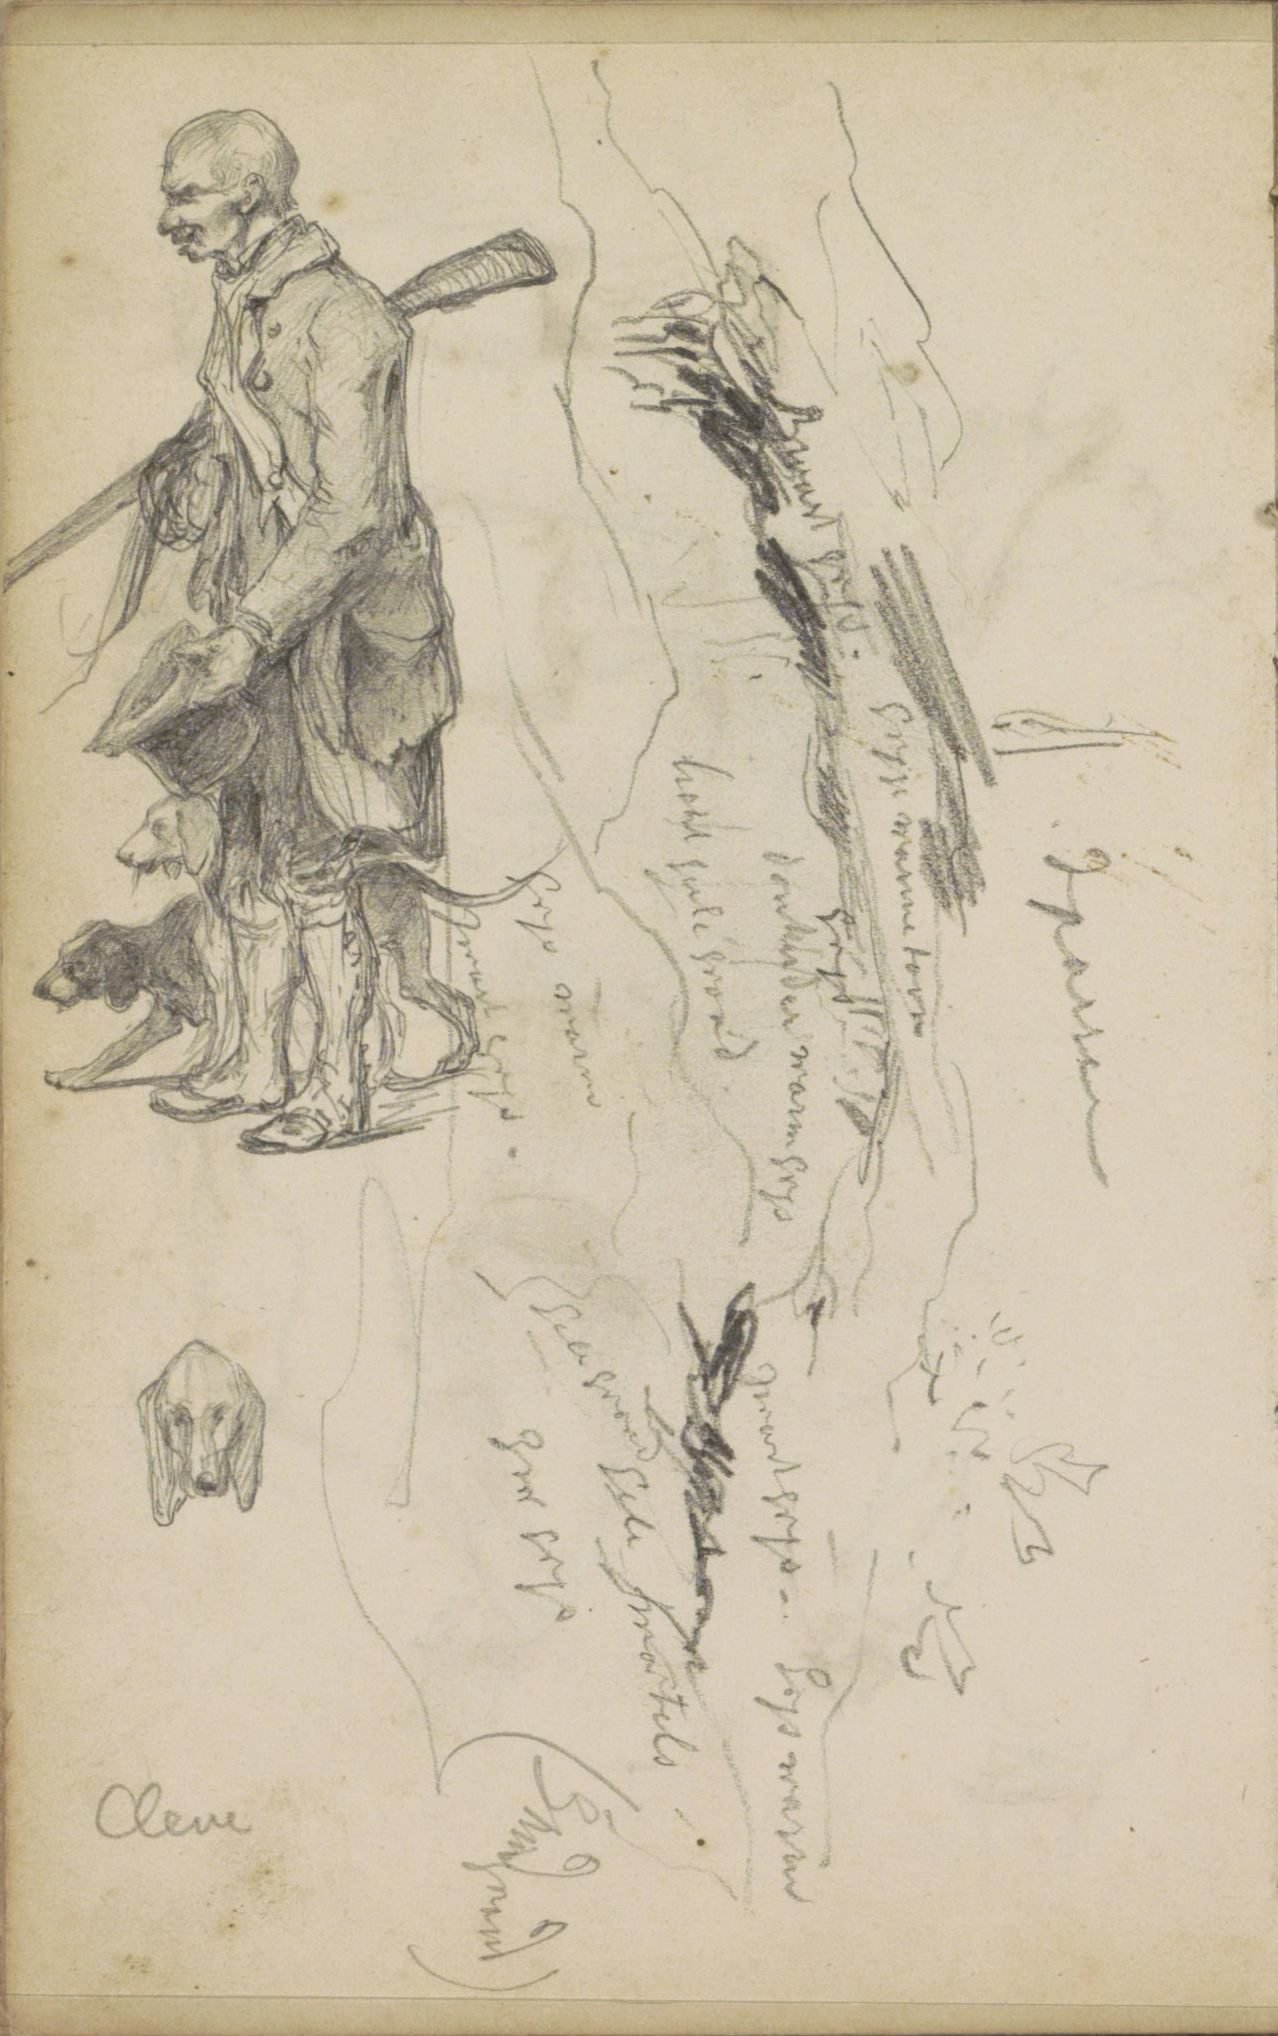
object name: sketchbook leaf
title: Jager met honden en een landschap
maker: johannes tavenraat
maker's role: draughtsman, painter, print maker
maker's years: 1809-1881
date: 1839-1872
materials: paper, pencil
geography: cleves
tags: landscapes, hunter, dog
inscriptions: annotation: ‘Cleve’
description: Blad 69 verso uit een schetsboek met 73 bladen.